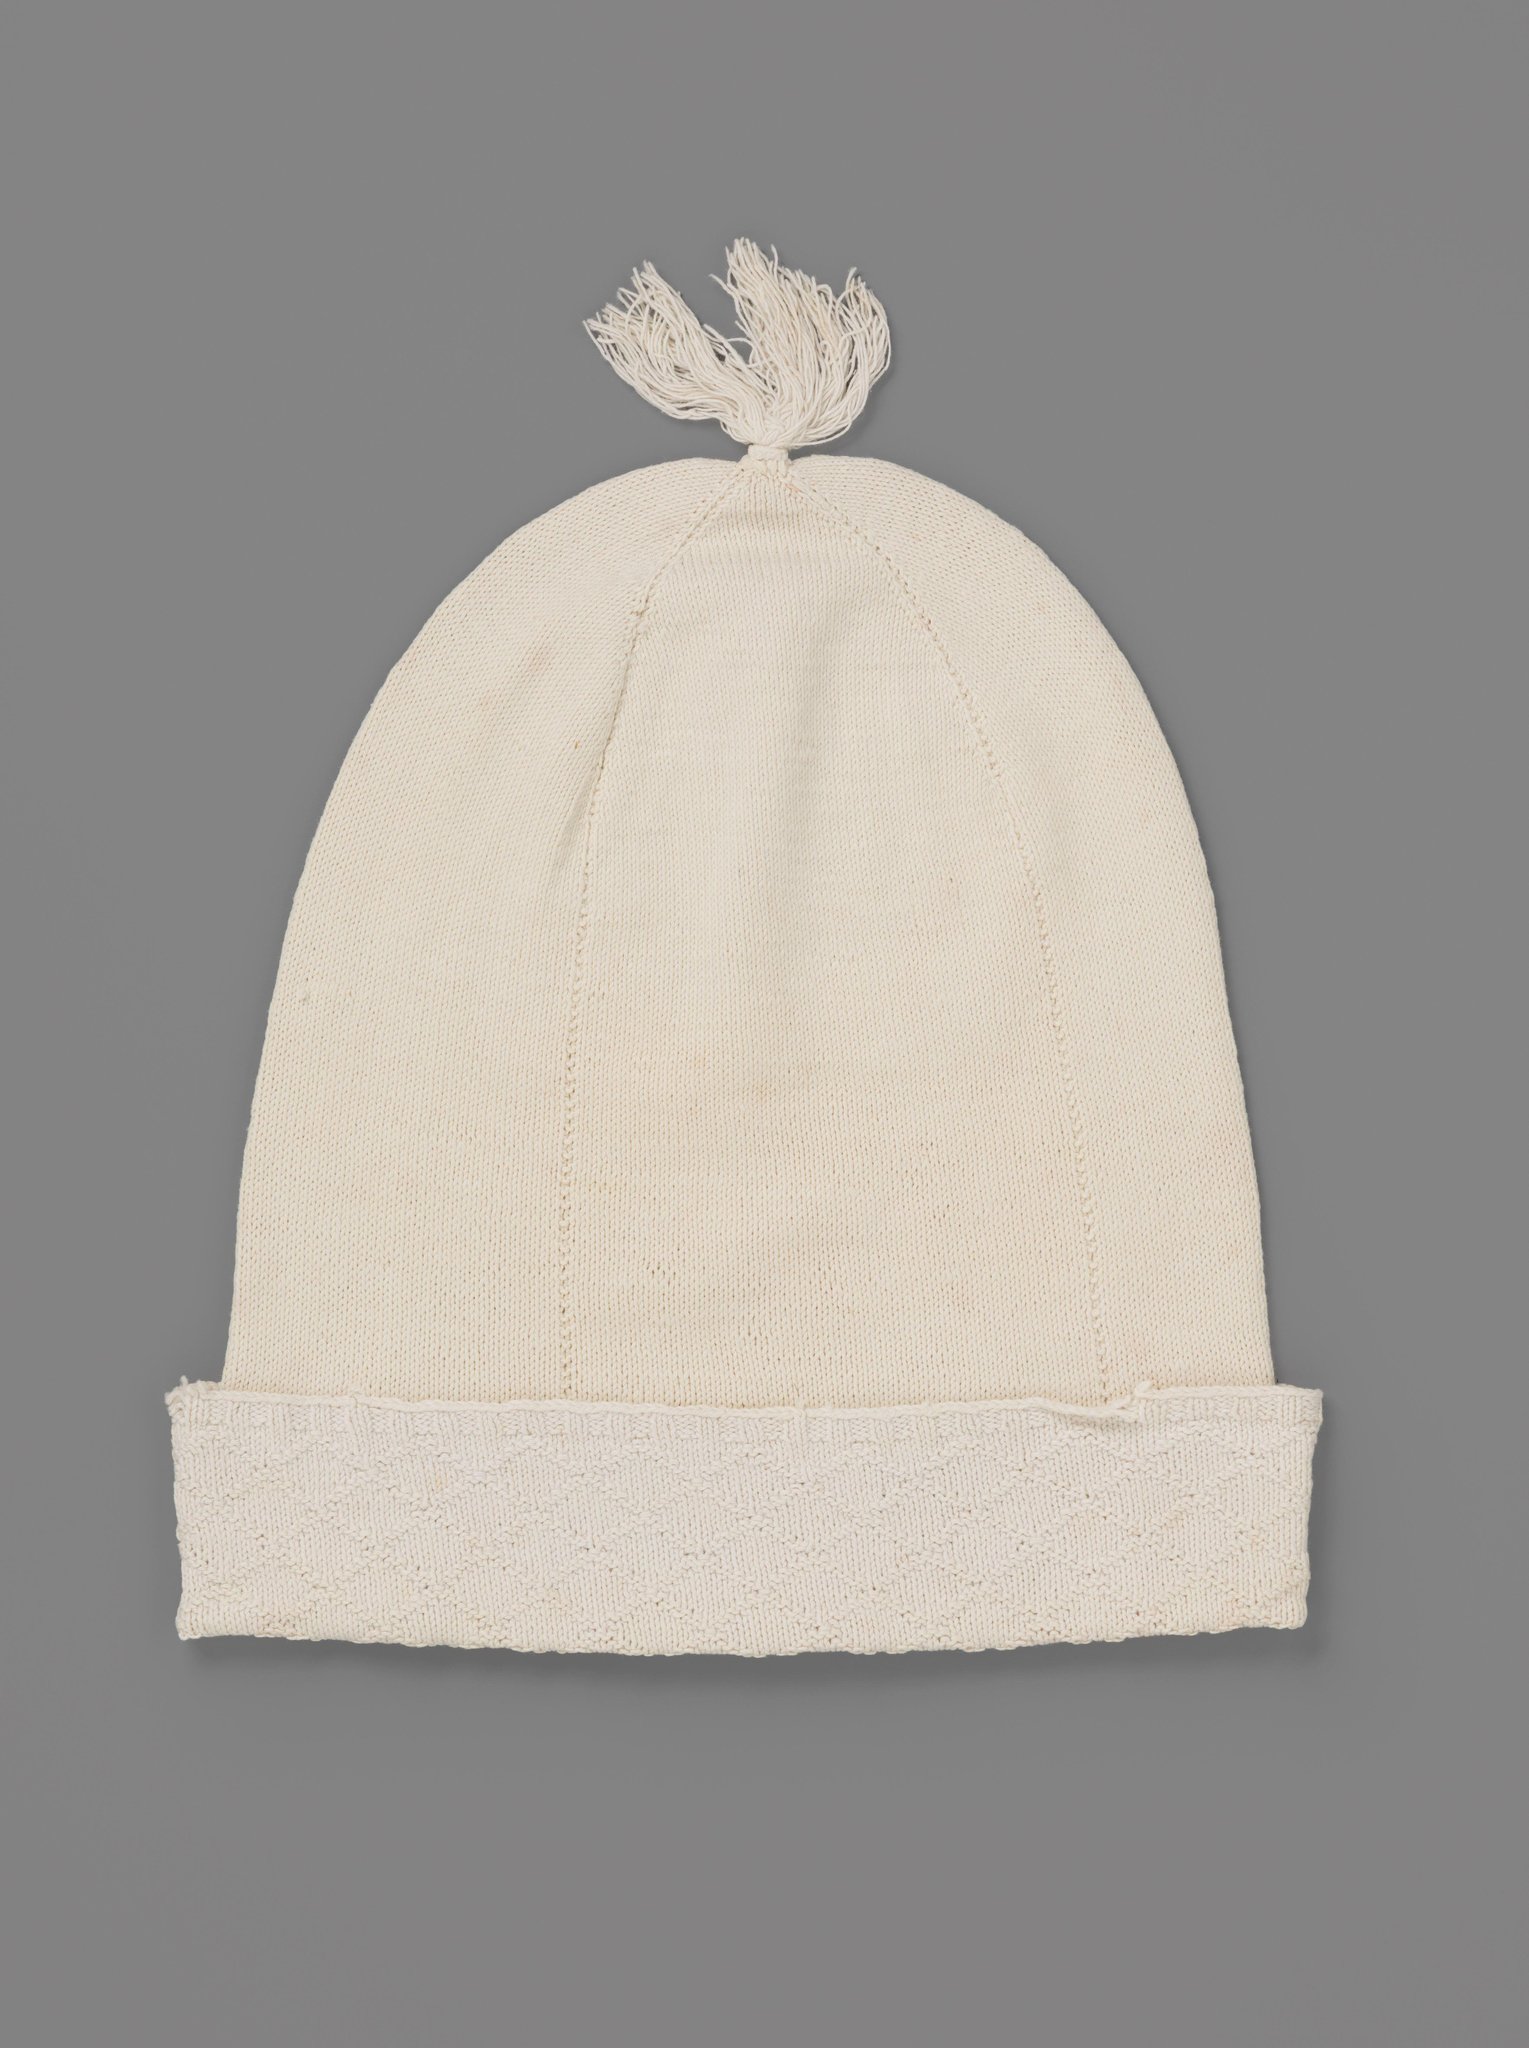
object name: kraamherenmuts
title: Kraamherenmuts van gebreide katoen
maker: Anonymous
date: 1775-1850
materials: cotton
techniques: knitting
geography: netherlands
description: Kraamherenmuts van gebreide katoen (tricotsteek). De muts heeft een kwast en een omgeslagen rand met ingebreide ruit. Onder rand gaat een ingebreid merk schuil: 'HX 0(of 8?)'.